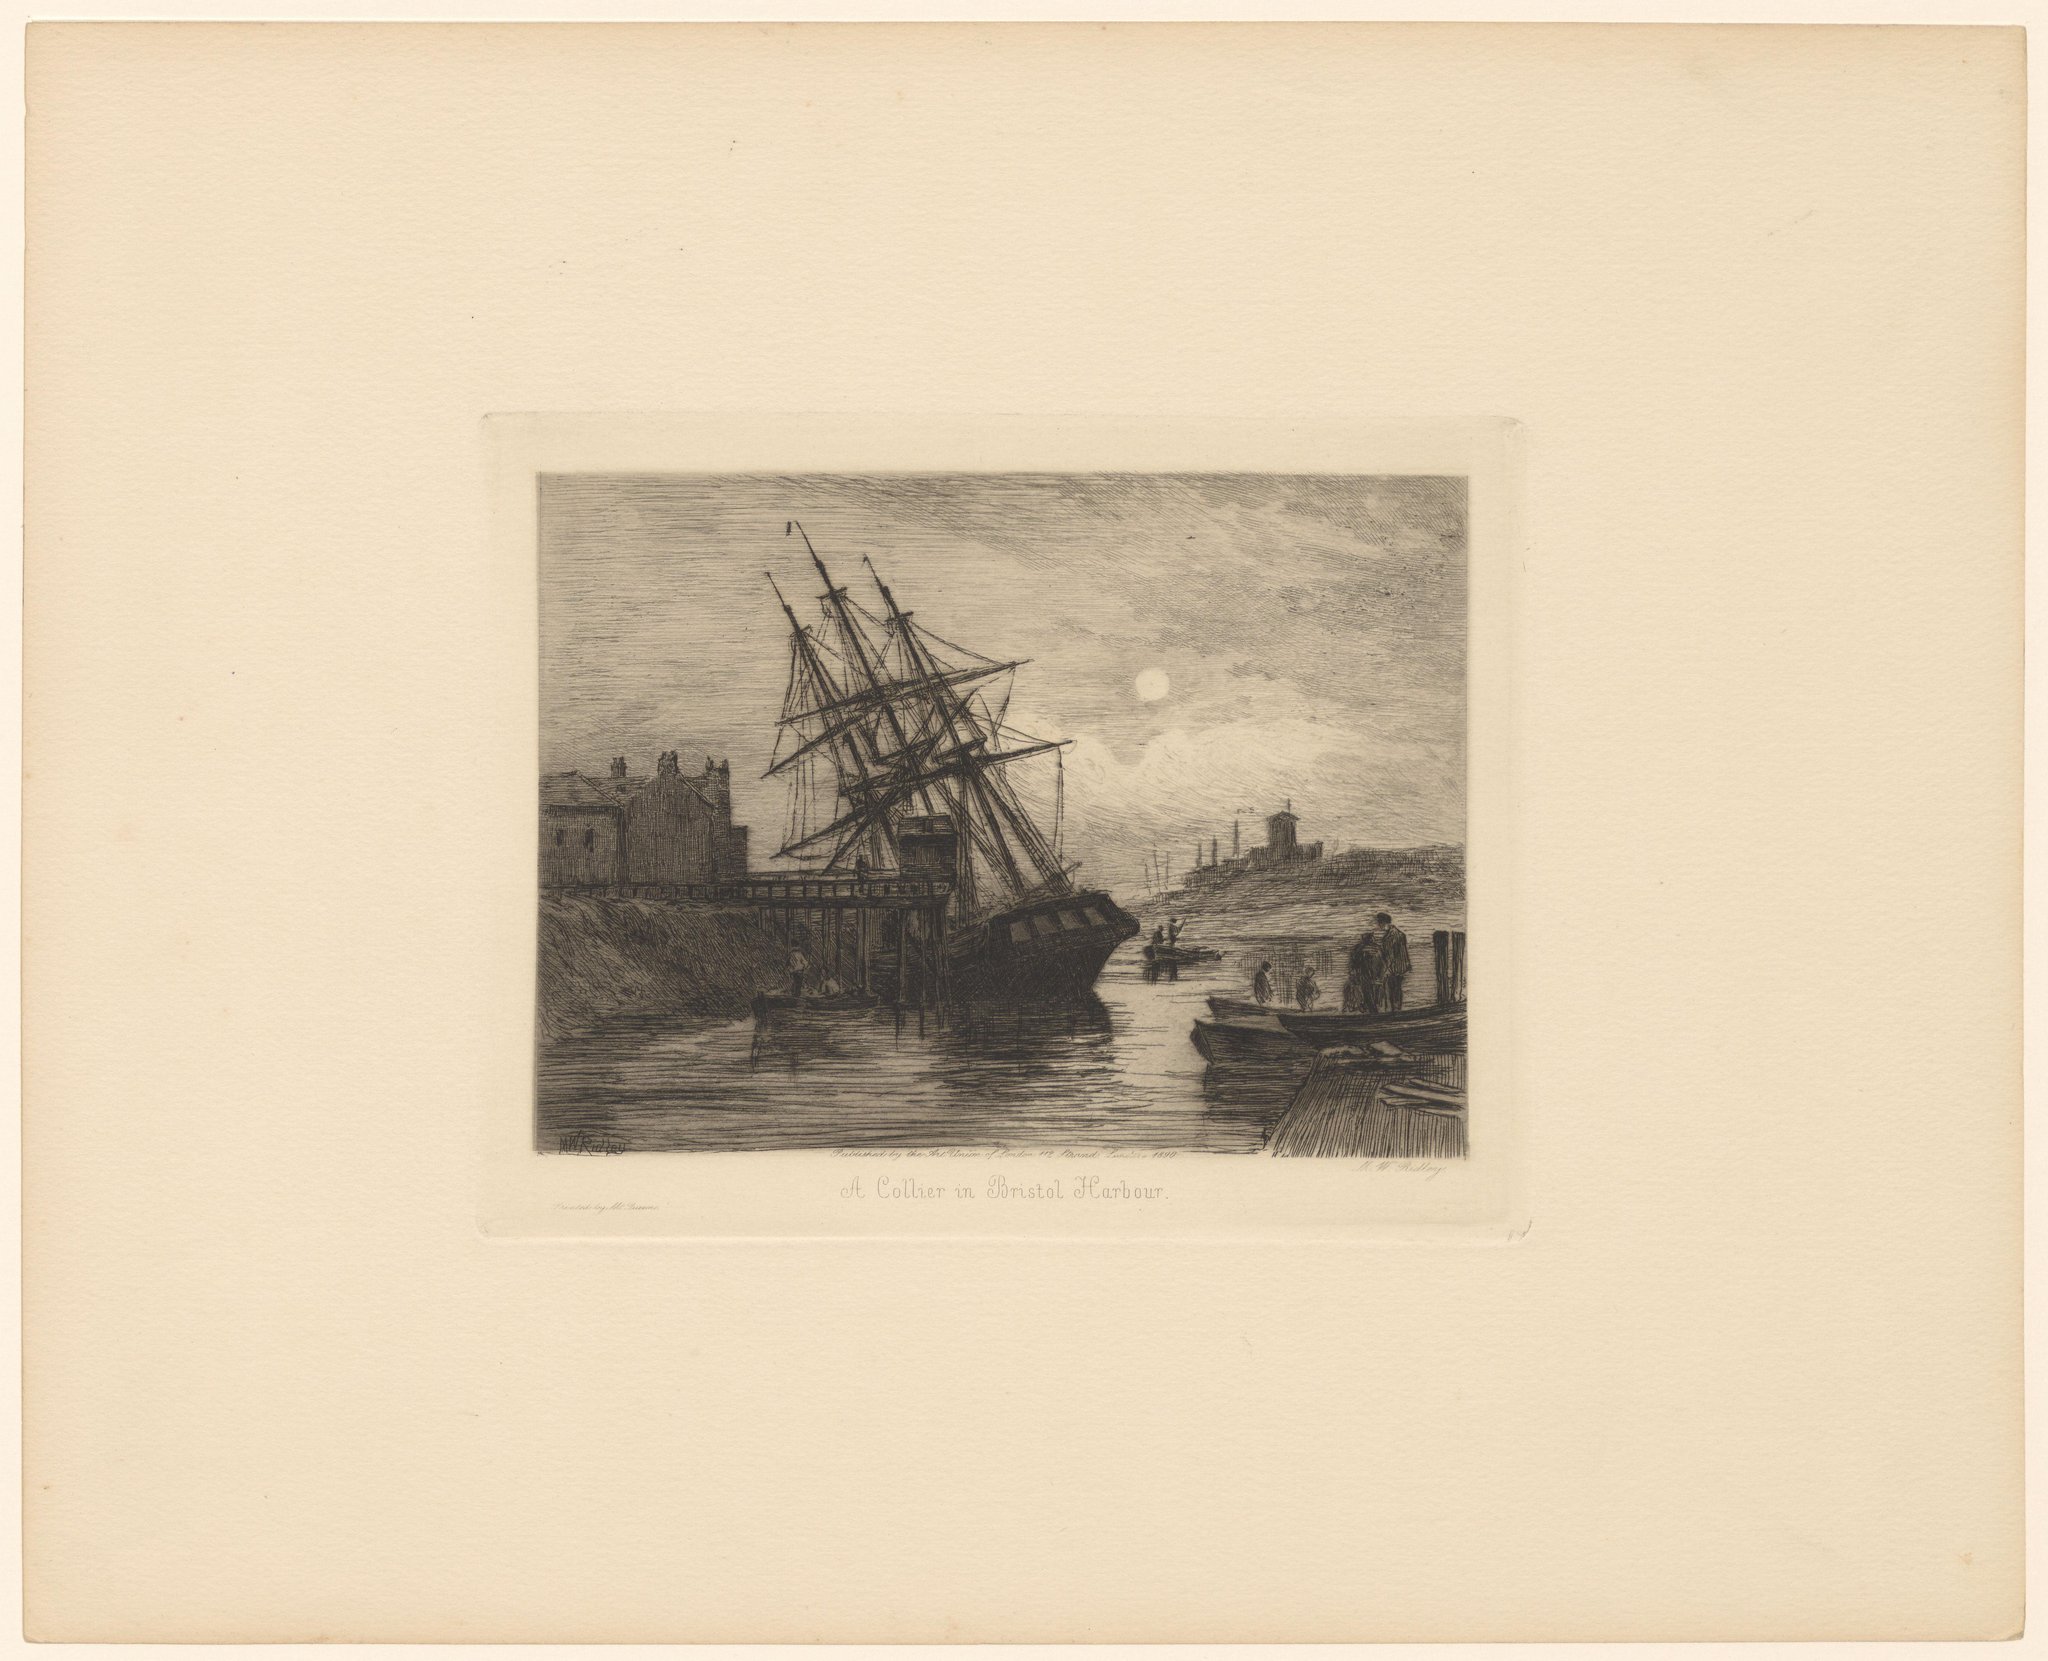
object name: print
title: Werf bij Bristol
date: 1890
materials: paper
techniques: etching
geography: london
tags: harbour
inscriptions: collector's mark: Lugt 2228